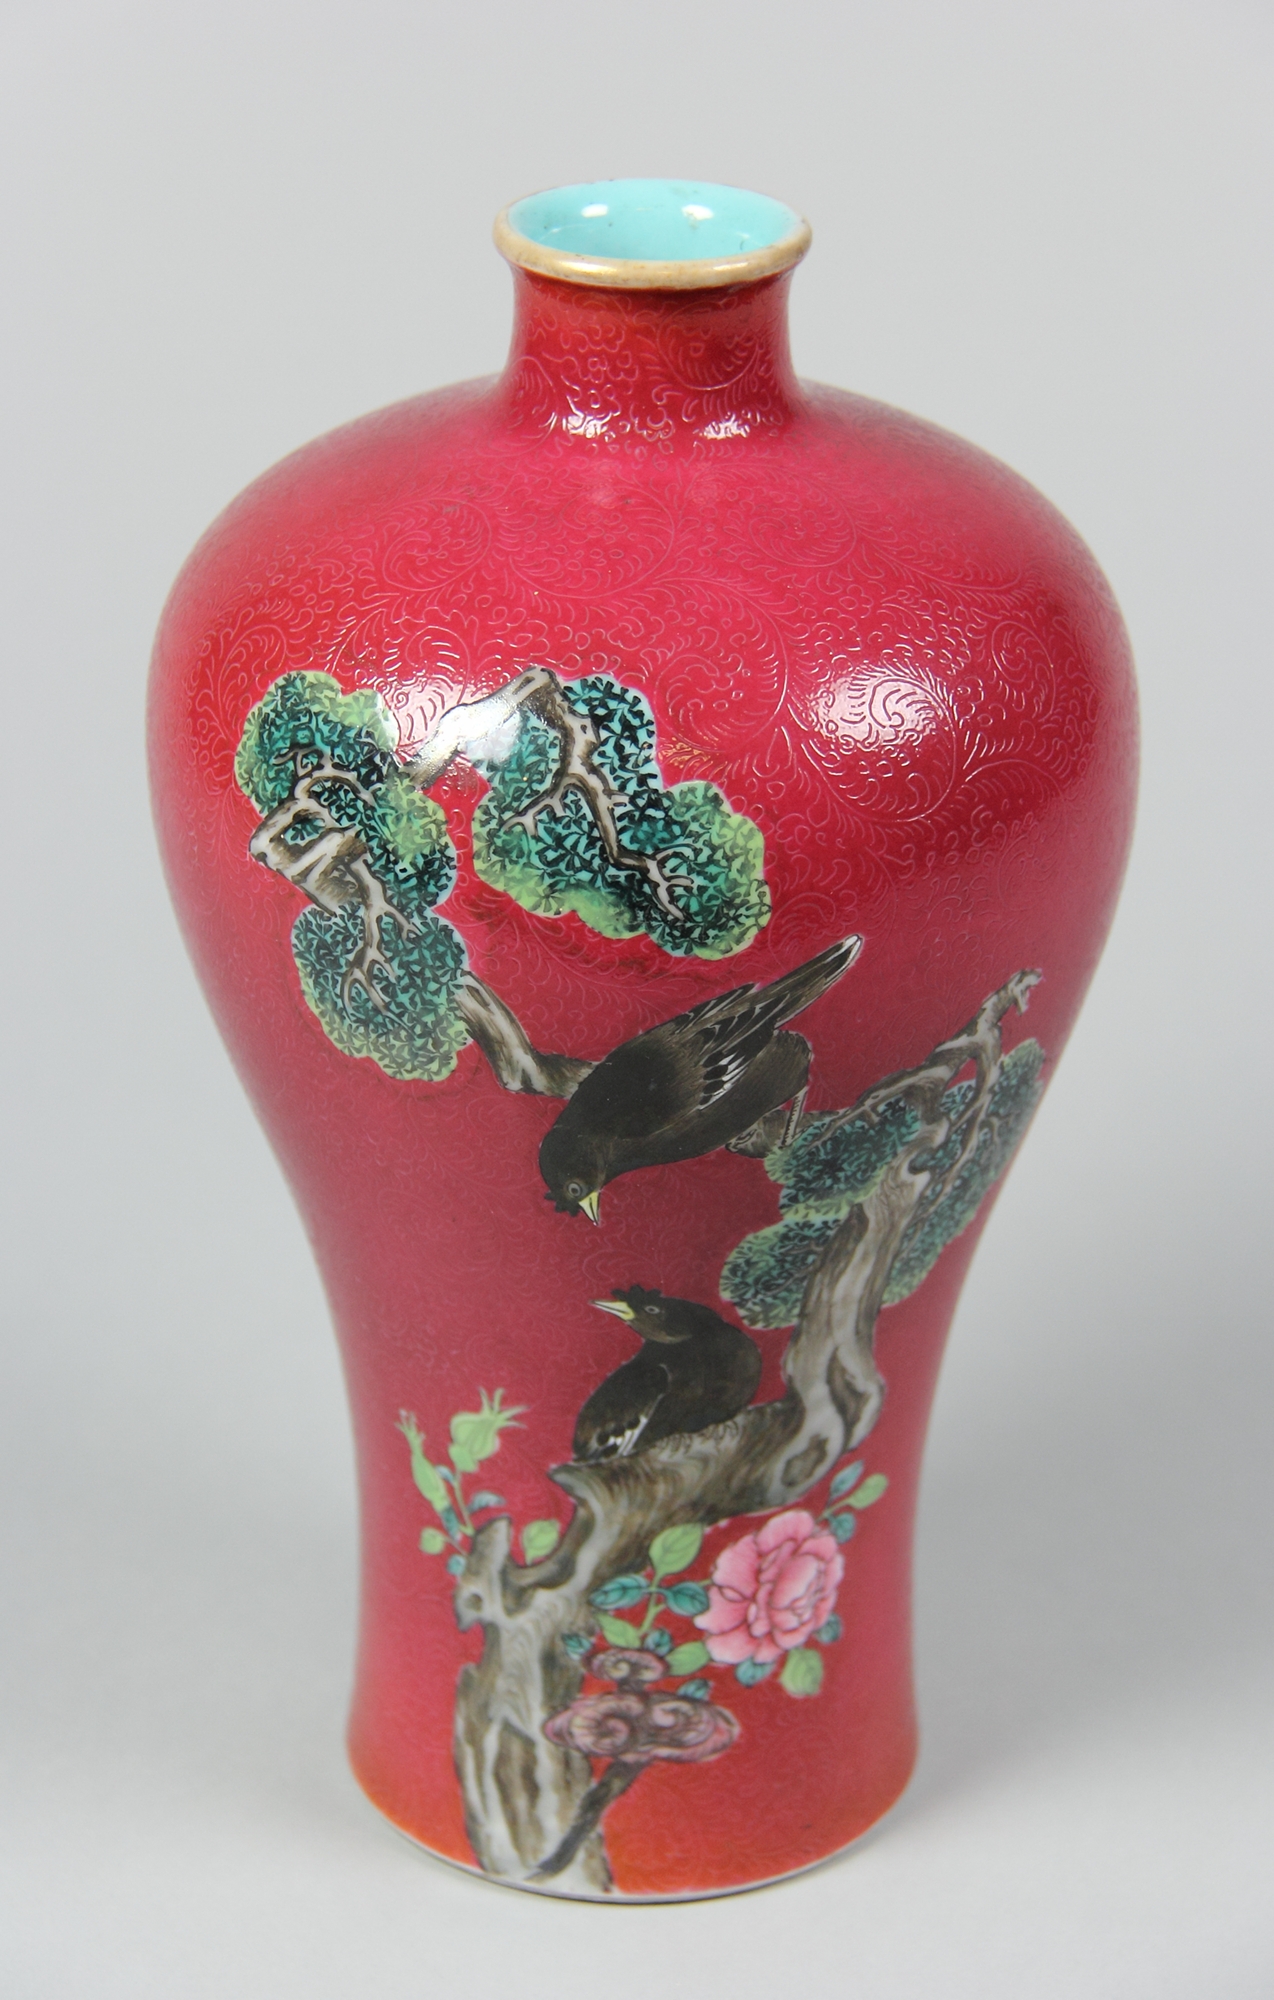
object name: vase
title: Meiping vase with birds and flowers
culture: chinese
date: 1767-1800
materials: enamel, porcelain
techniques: engraving, overglaze, painting, polychrome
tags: birds